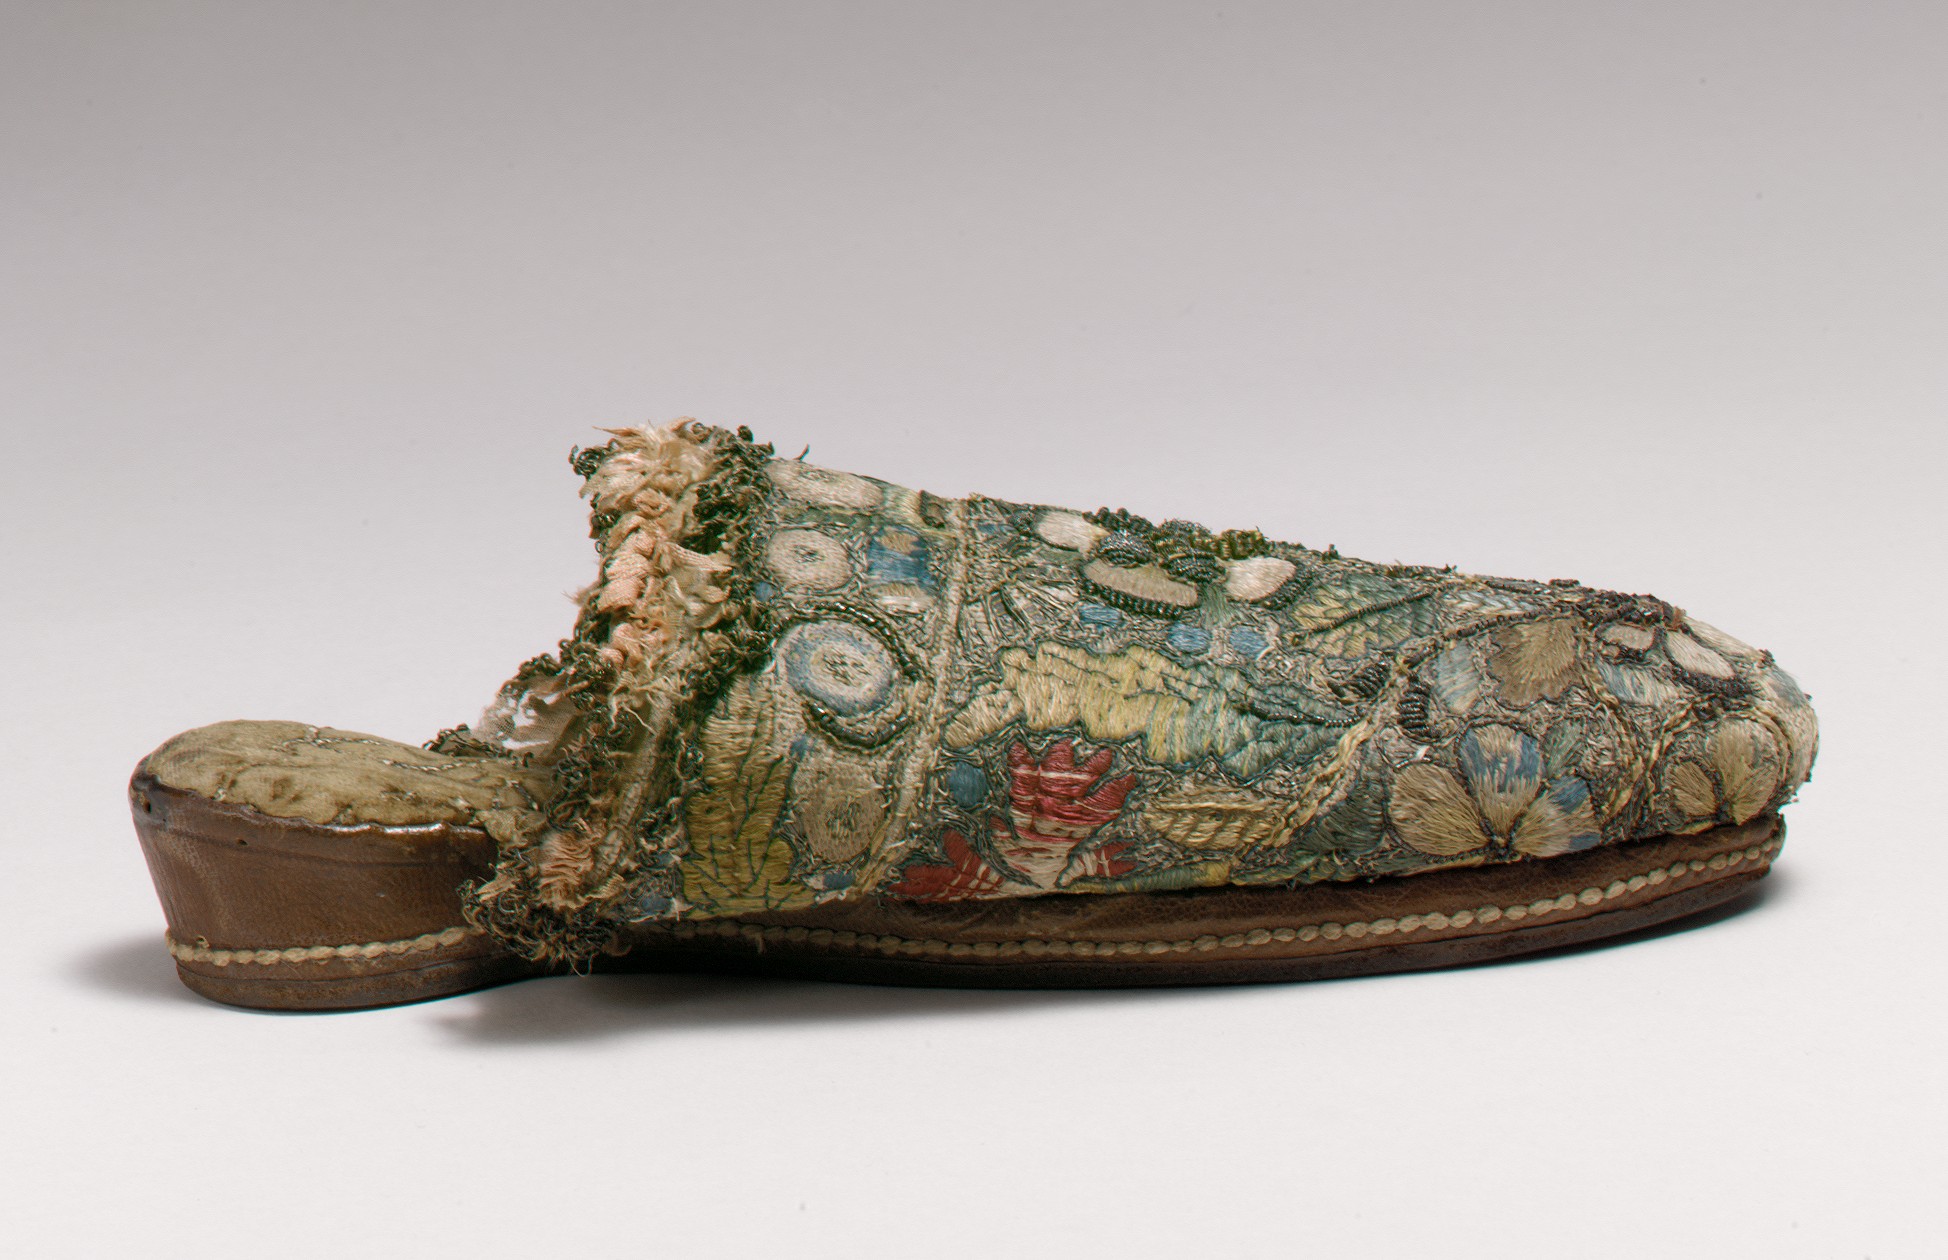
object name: mule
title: Mules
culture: british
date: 1601-1625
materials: leather, linen, silk